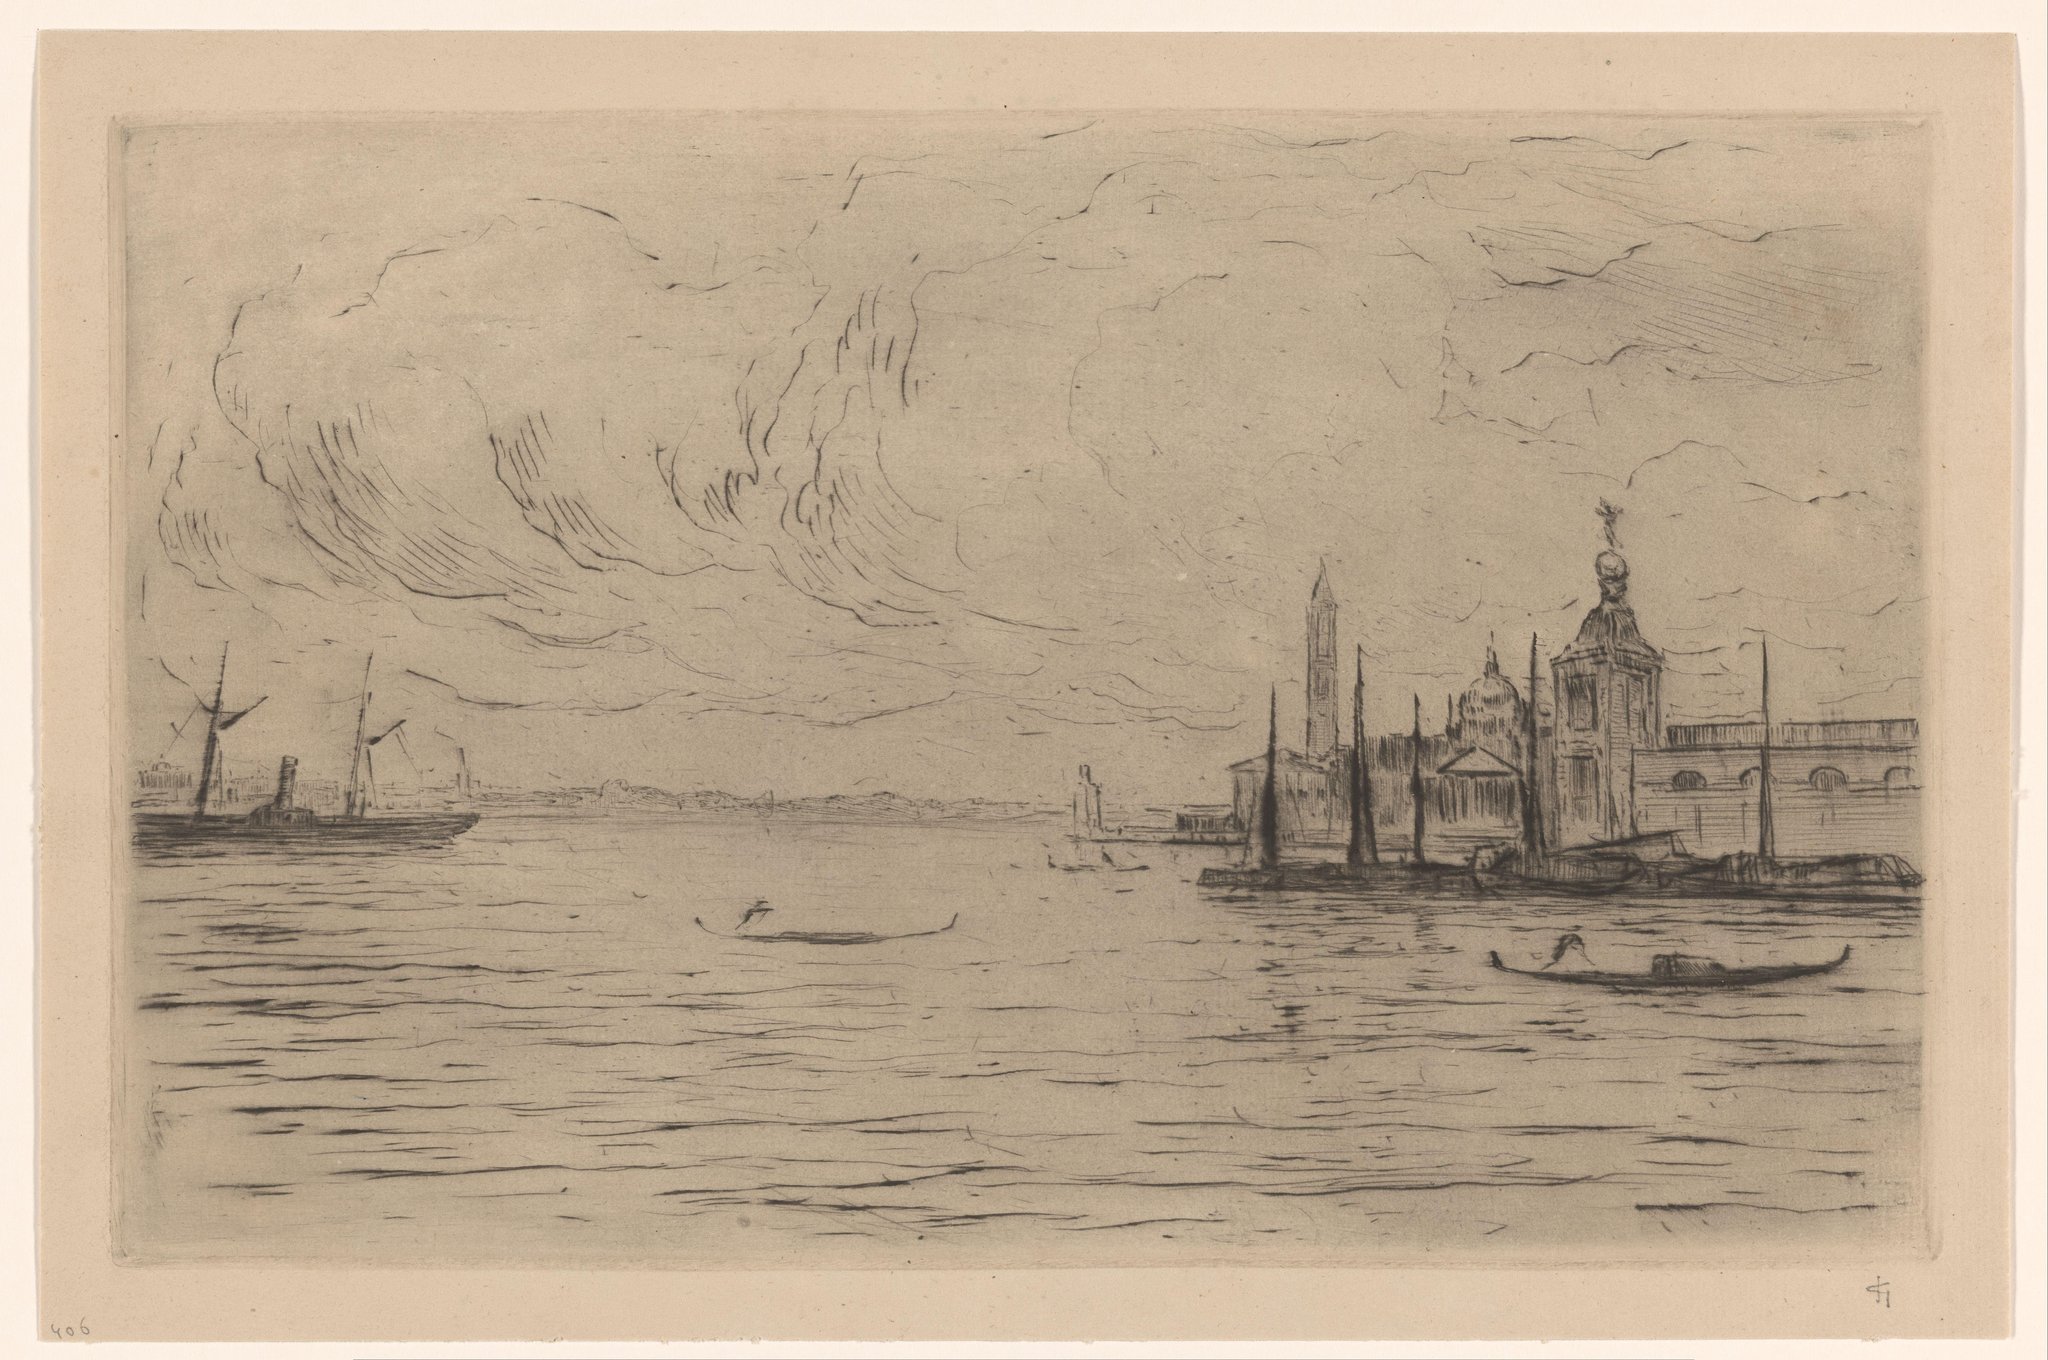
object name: print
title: Gezicht op Punta della Dogana in Venetië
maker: carel nicolaas storm van s-gravesande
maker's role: draughtsman, print maker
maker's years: 1841-1924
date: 1851-1902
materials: paper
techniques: drypoint, intaglio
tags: customs, canals, waters (in city)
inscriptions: collector's mark: Lugt 2228, number: ‘406’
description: Mogelijk vermeld in: Storm van 's-Gravesande, Charles. Catalogue des eaux-fortes et lithographies. New York: s.n., 1903, of in een onbekende latere uitgave van het manuscript. Vermoedelijk vermeld als catalogusnummer 406.